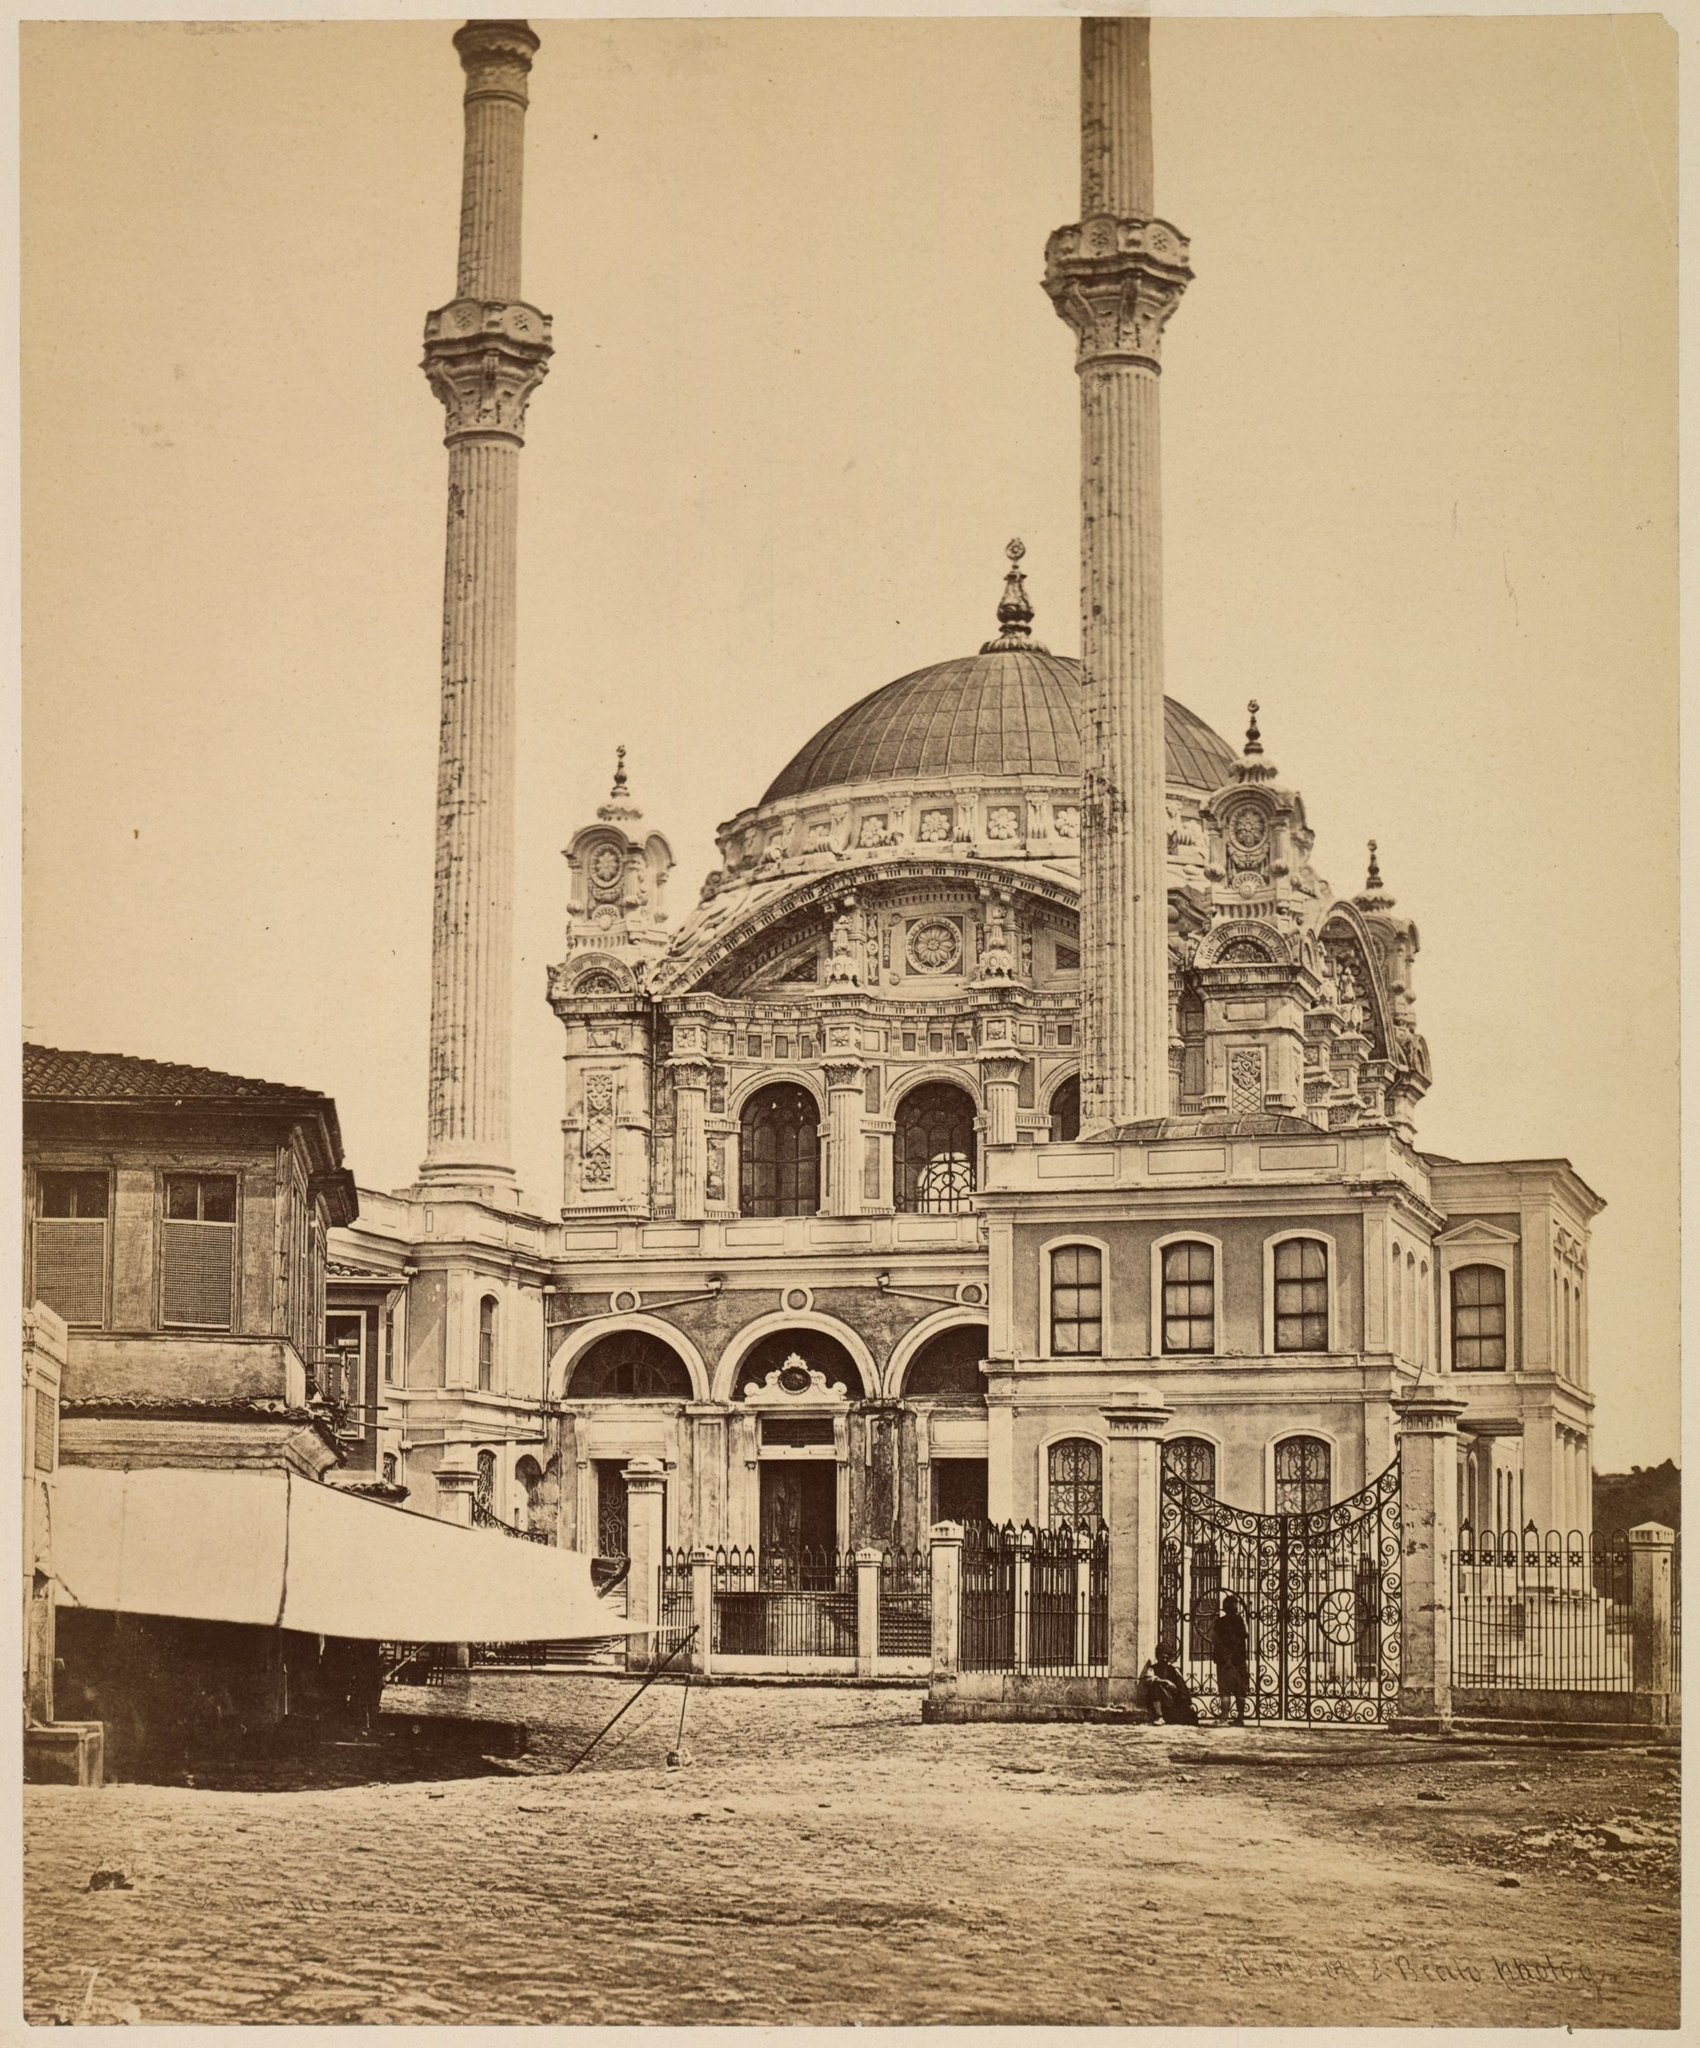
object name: photograph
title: Gezicht op de Ortaköy-moskee in Istanboel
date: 1854-1867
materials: cardboard, paper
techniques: albumen print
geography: istanbul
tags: temple, shrine ~ islam, mohammedanism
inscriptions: inscription: ‘[onleesbaar]’, number: ‘7’